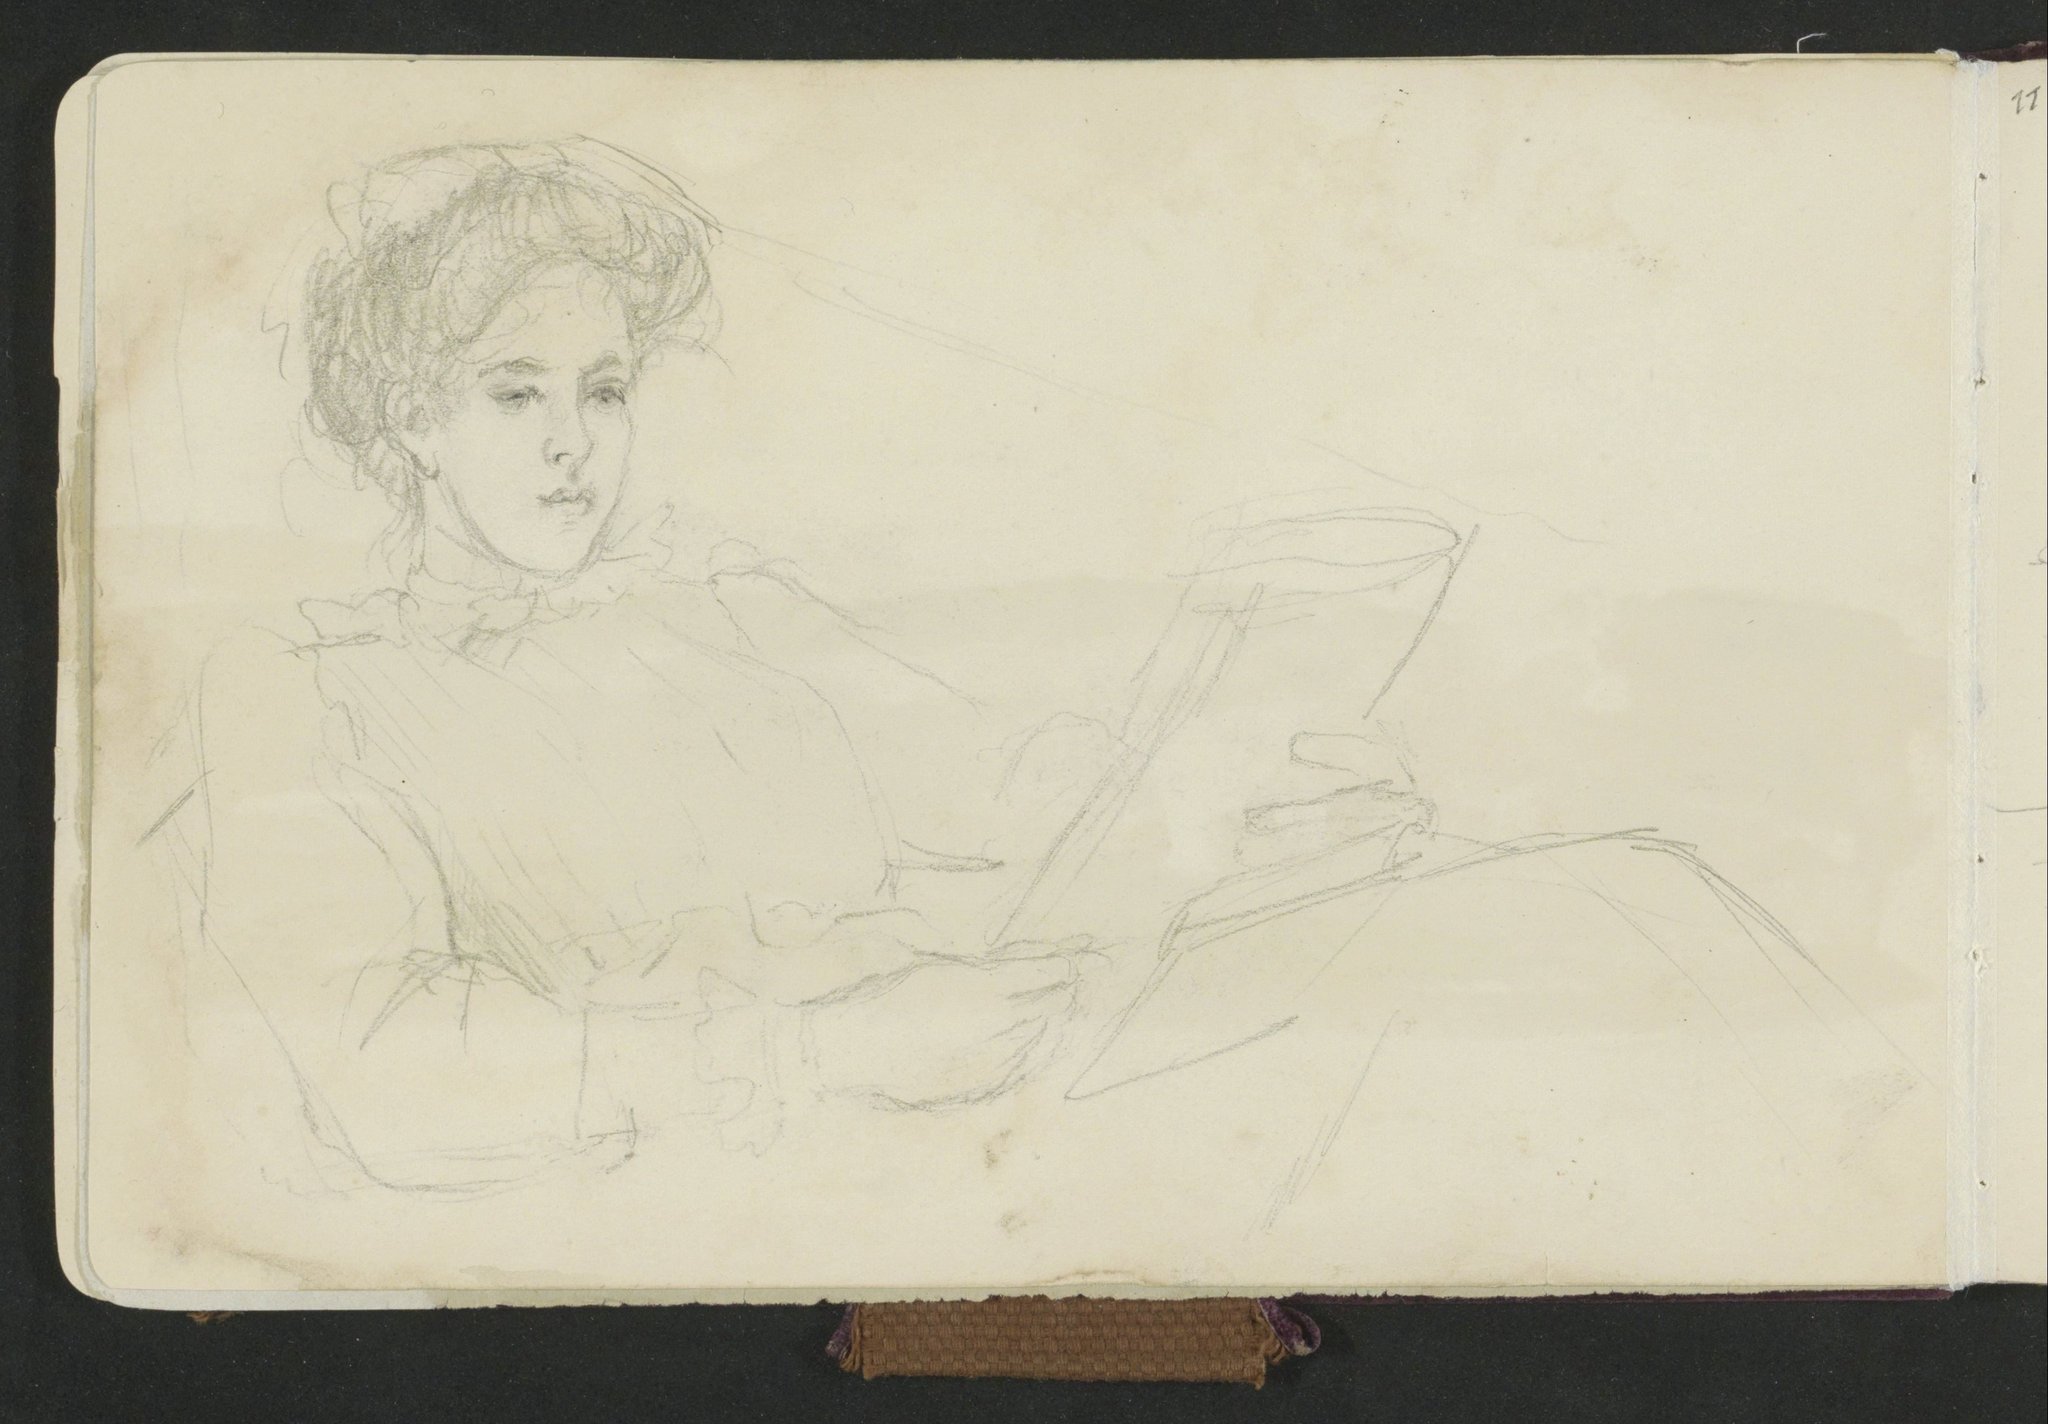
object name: sketchbook leaf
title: Lezende vrouw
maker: jozef israëls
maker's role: draughtsman, painter, print maker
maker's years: 1824-1911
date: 1885-1911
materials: paper, pencil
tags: reading, sitting figure - aa - female human figure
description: Blad 10 verso uit een schetsboek met 26 bladen.